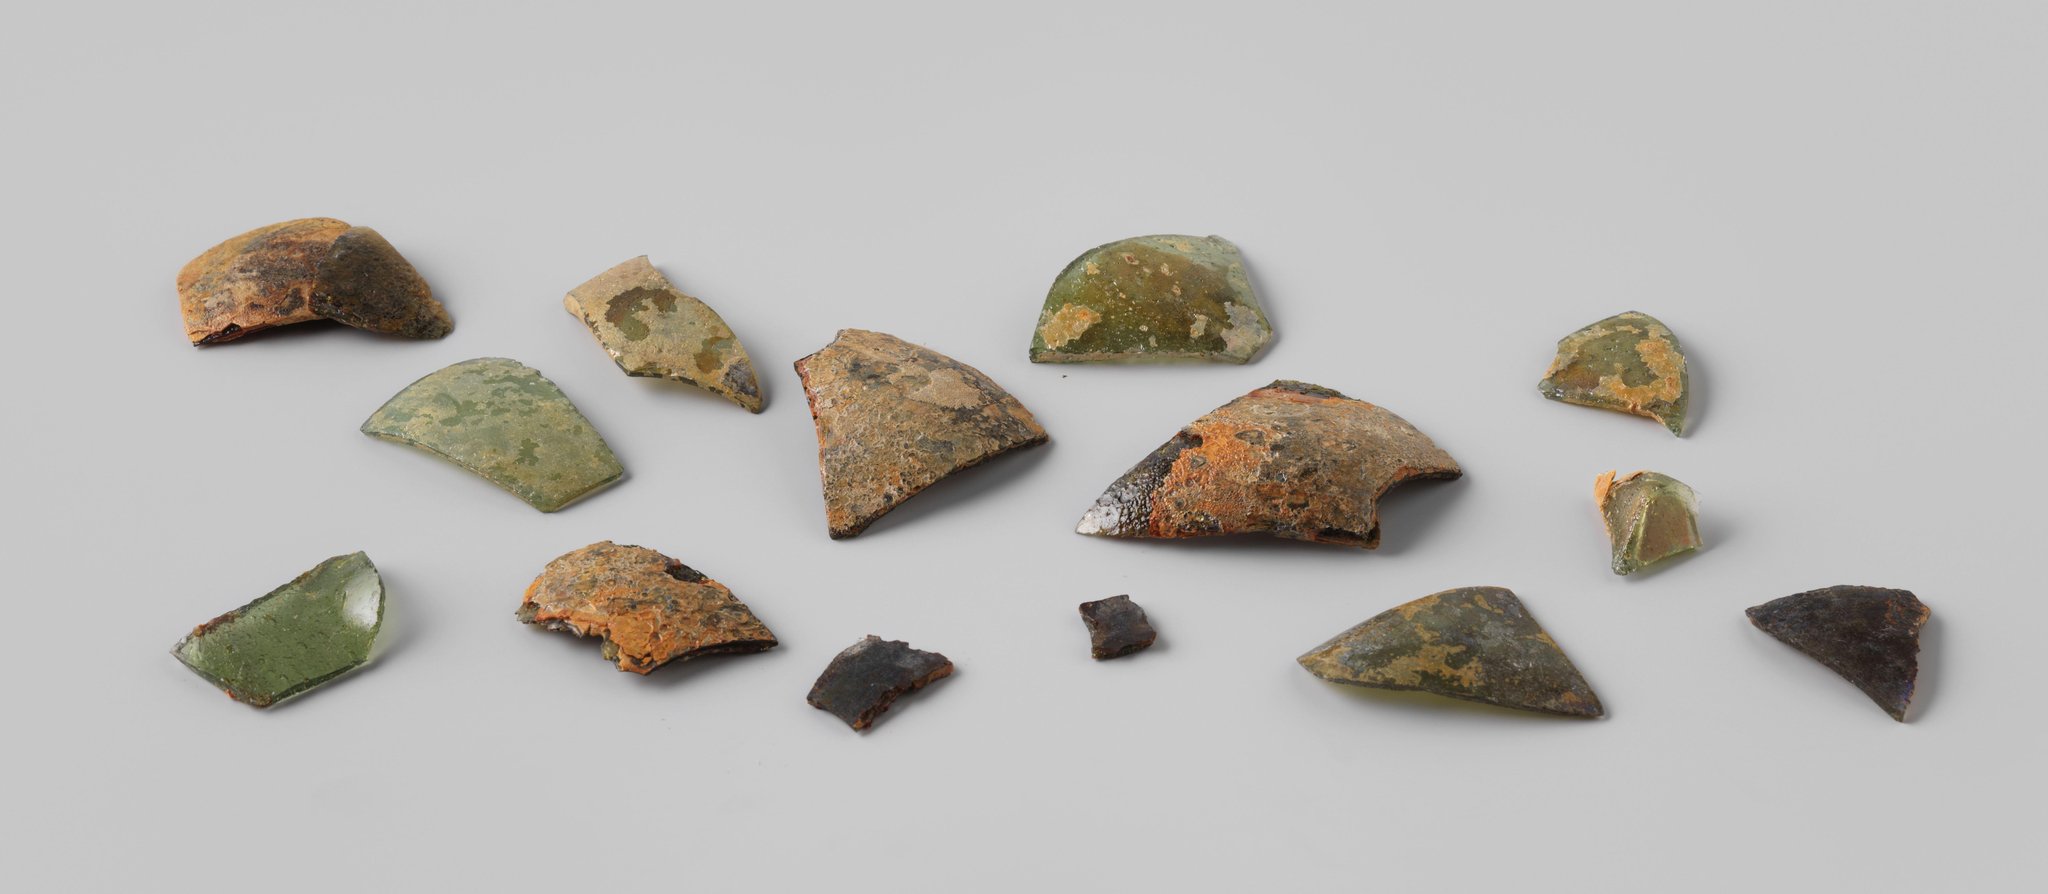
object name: wine bottle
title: Scherven van wijnflessen uit het wrak van de Oost-Indiëvaarder 't Vliegend Hart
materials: glass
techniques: green glass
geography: netherlands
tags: 't vliegend hart (schip), verenigde oostindische compagnie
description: Scherven van uivormige wijnflessen van groen glas waar rode (port)wijn in heeft gezeten.